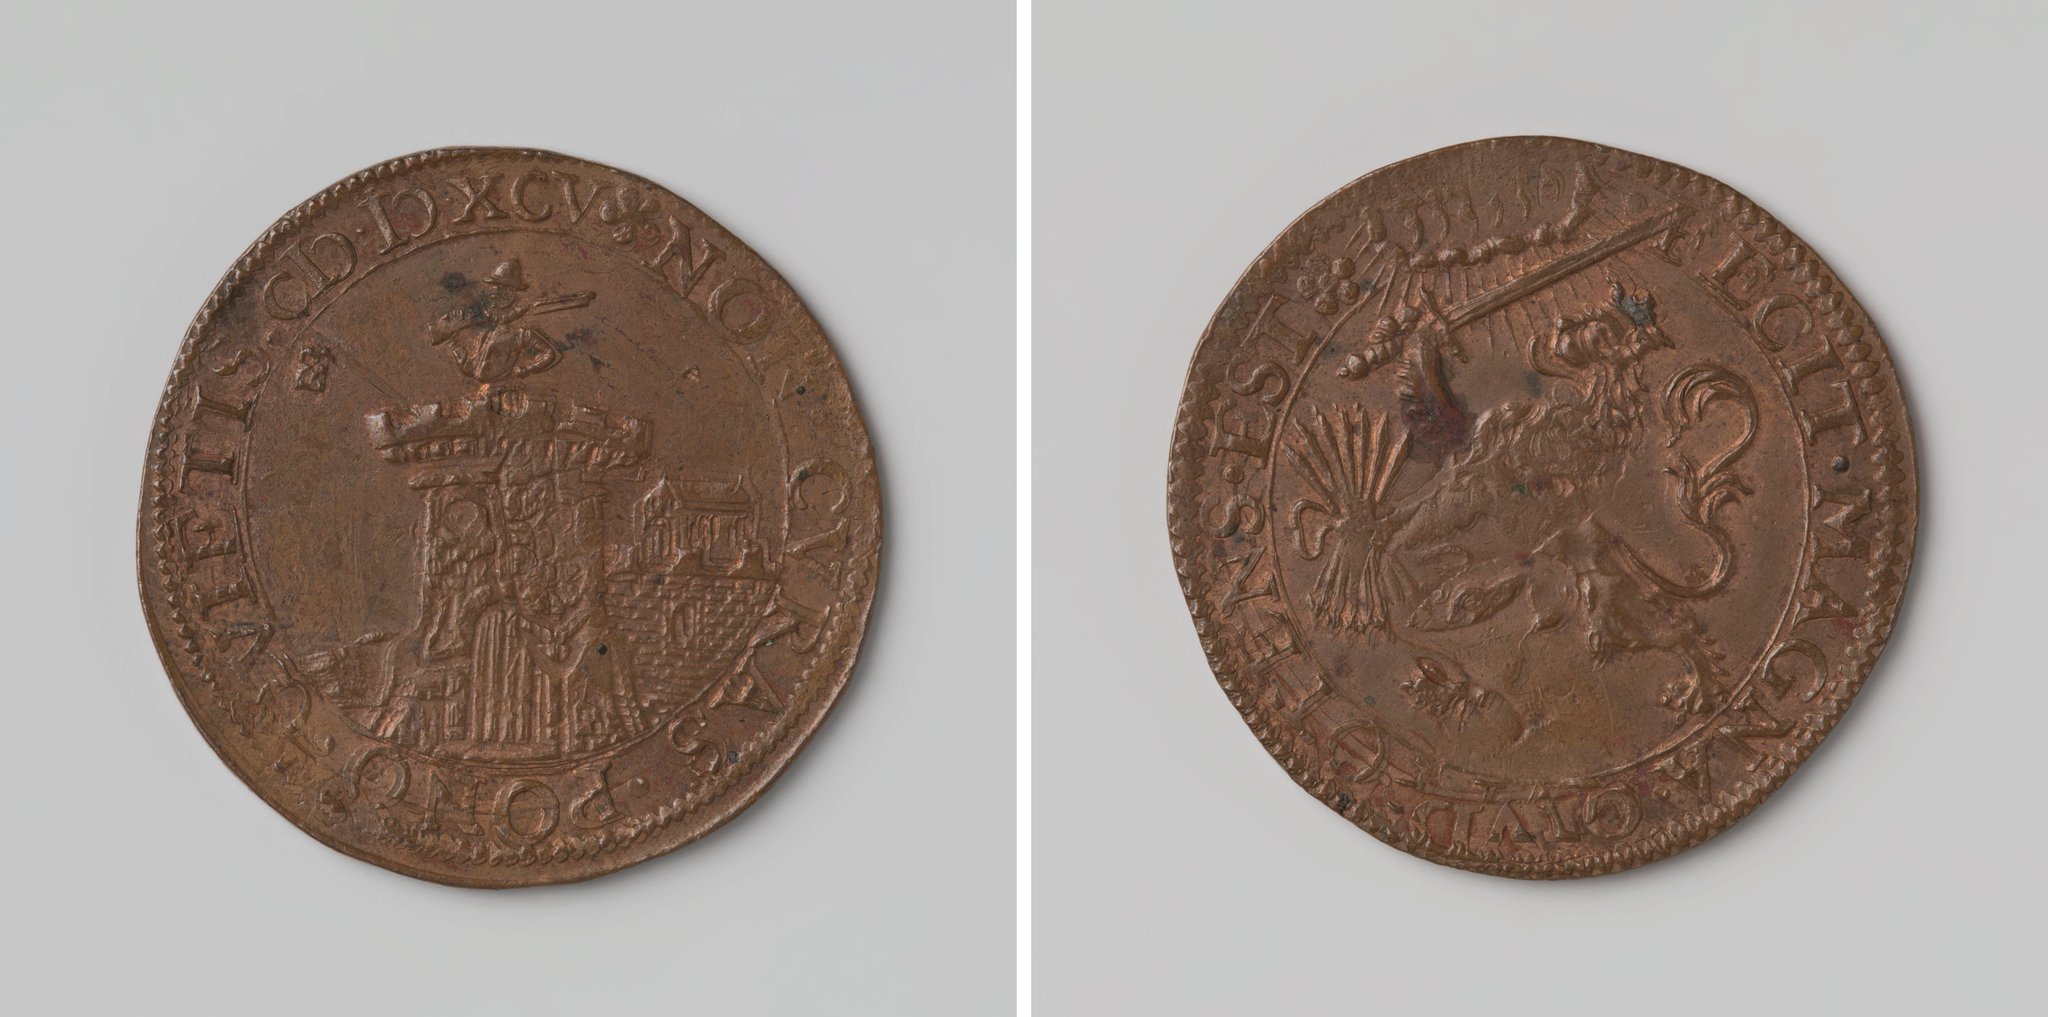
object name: jeton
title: Vredesonderhandelingen te Middelburg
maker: Anonymous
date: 1595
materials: copper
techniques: striking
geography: dordrecht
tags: middelburg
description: Koperen penning. Voorzijde: soldaat met geweer over zijn schouder, staande op toren binnen omschrift. Keerzijde: gekroonde leeuw met zwaard en bundel van zeven pijlen in klauwen beschenen door hemellichr, waarin naam van Jehova in Hebreeuws schrift zichtbaar is binnen omschrift